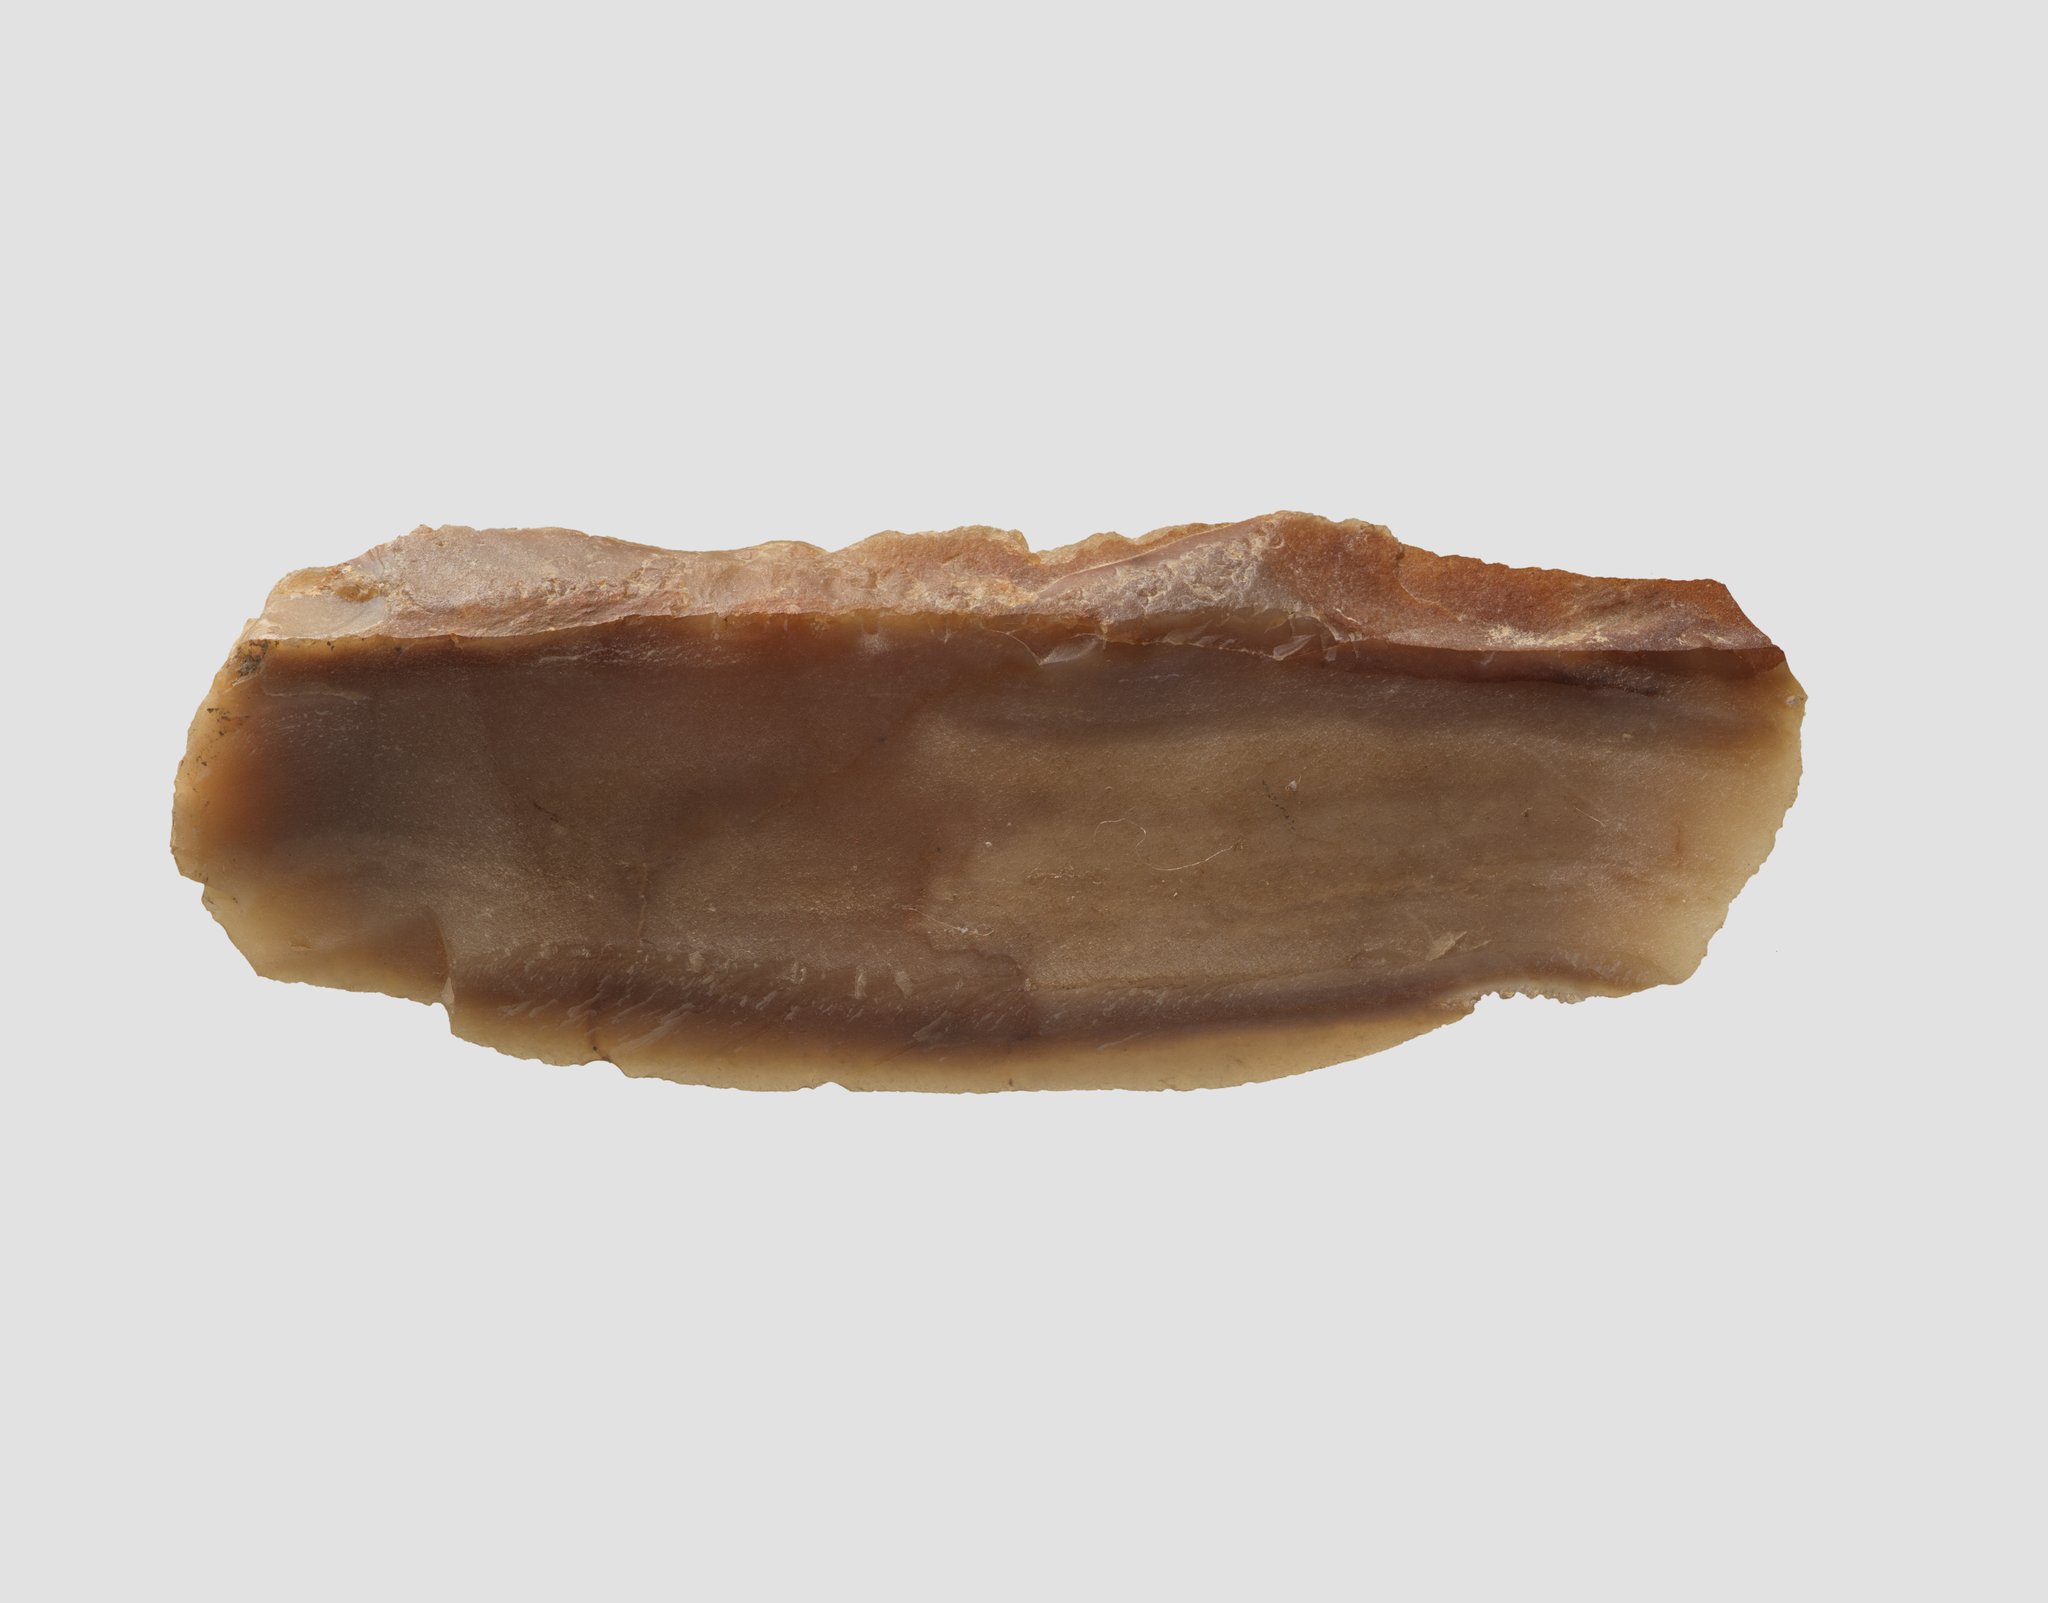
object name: knife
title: Blade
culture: ghassulian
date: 4600-3600 BCE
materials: stone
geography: levant